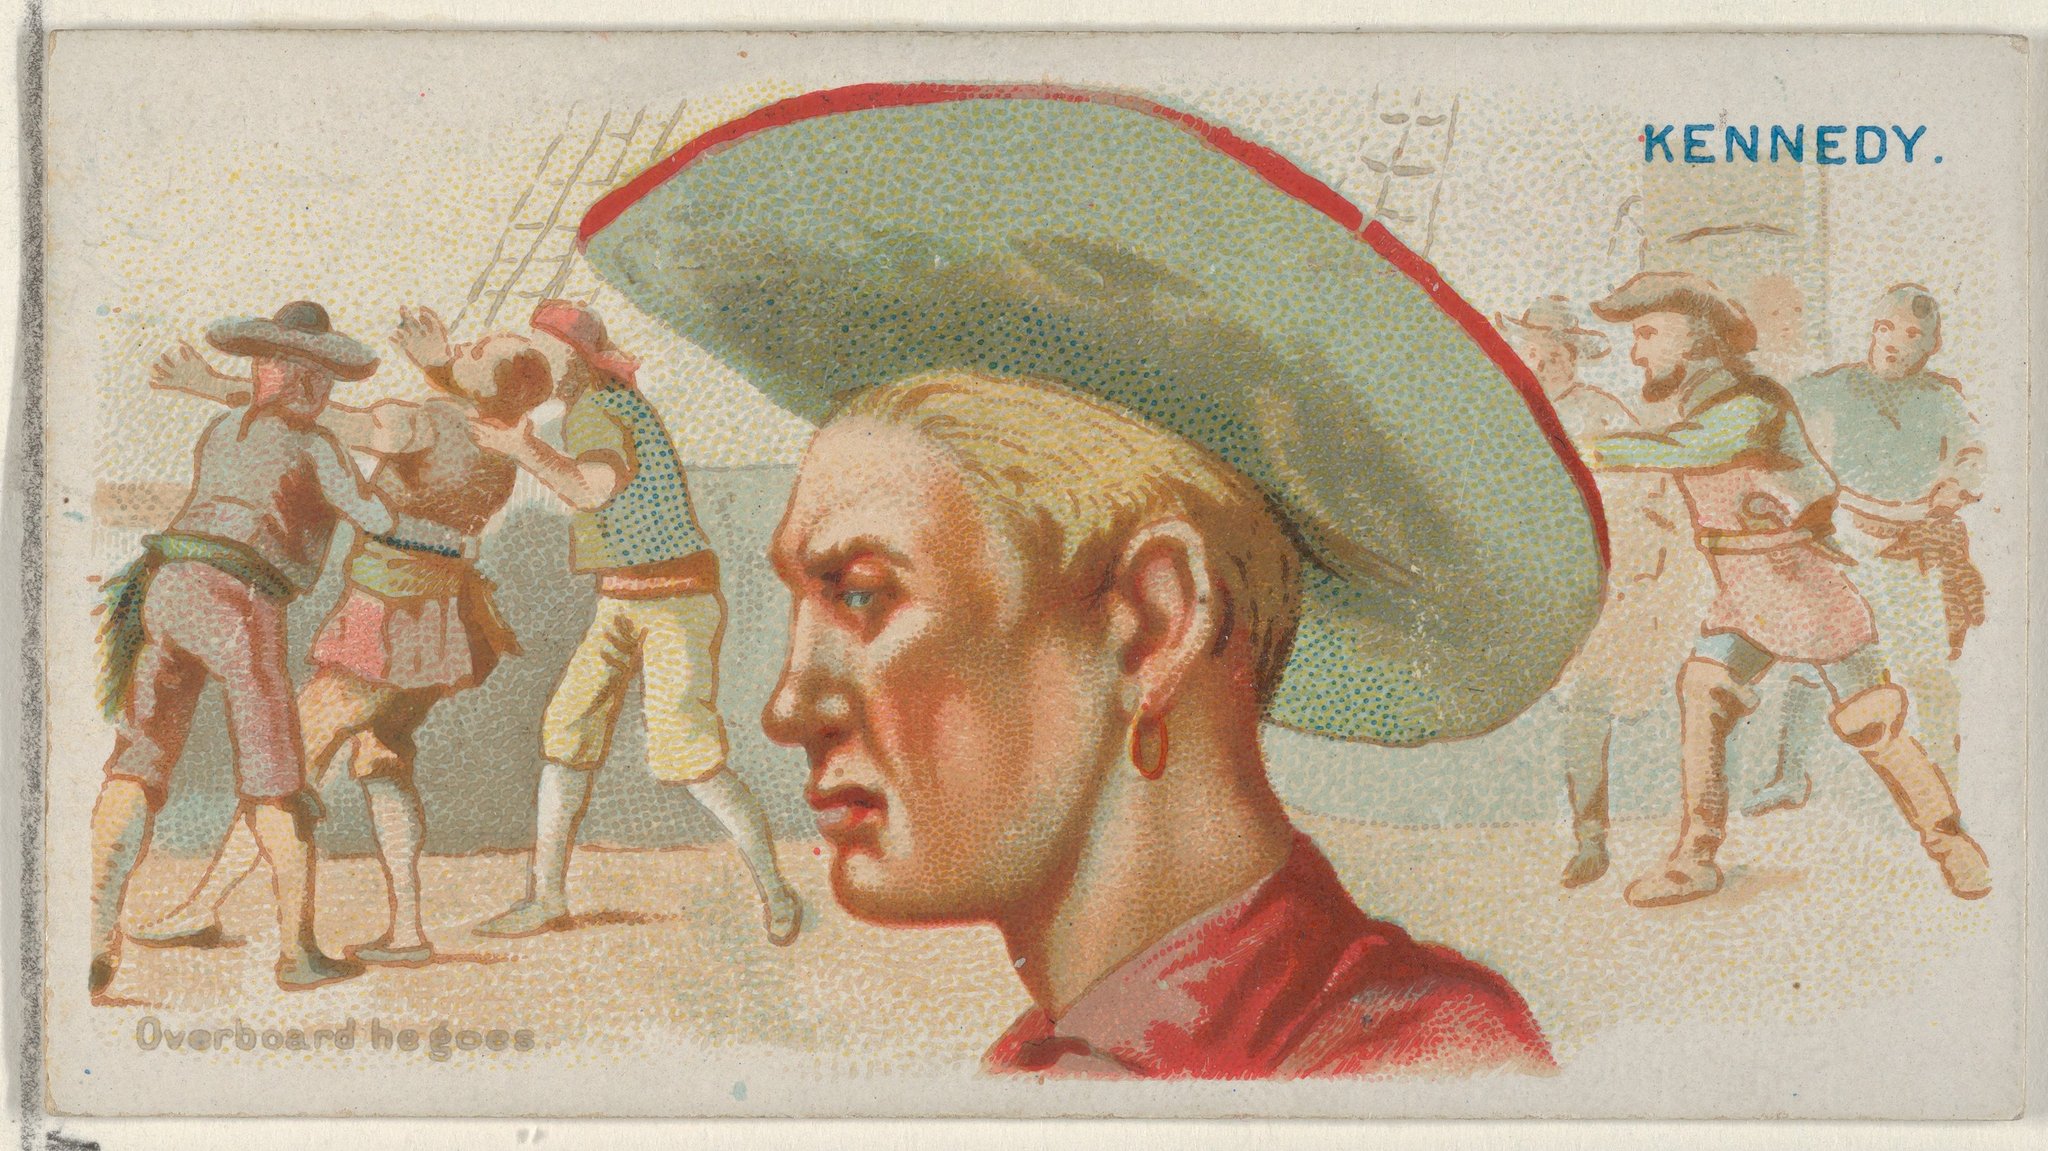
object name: print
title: Walter Kennedy, Overboard He Goes, from the Pirates of the Spanish Main series (N19) for Allen & Ginter Cigarettes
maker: allen & ginter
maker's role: publisher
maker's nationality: american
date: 1888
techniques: color lithograph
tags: men,profiles